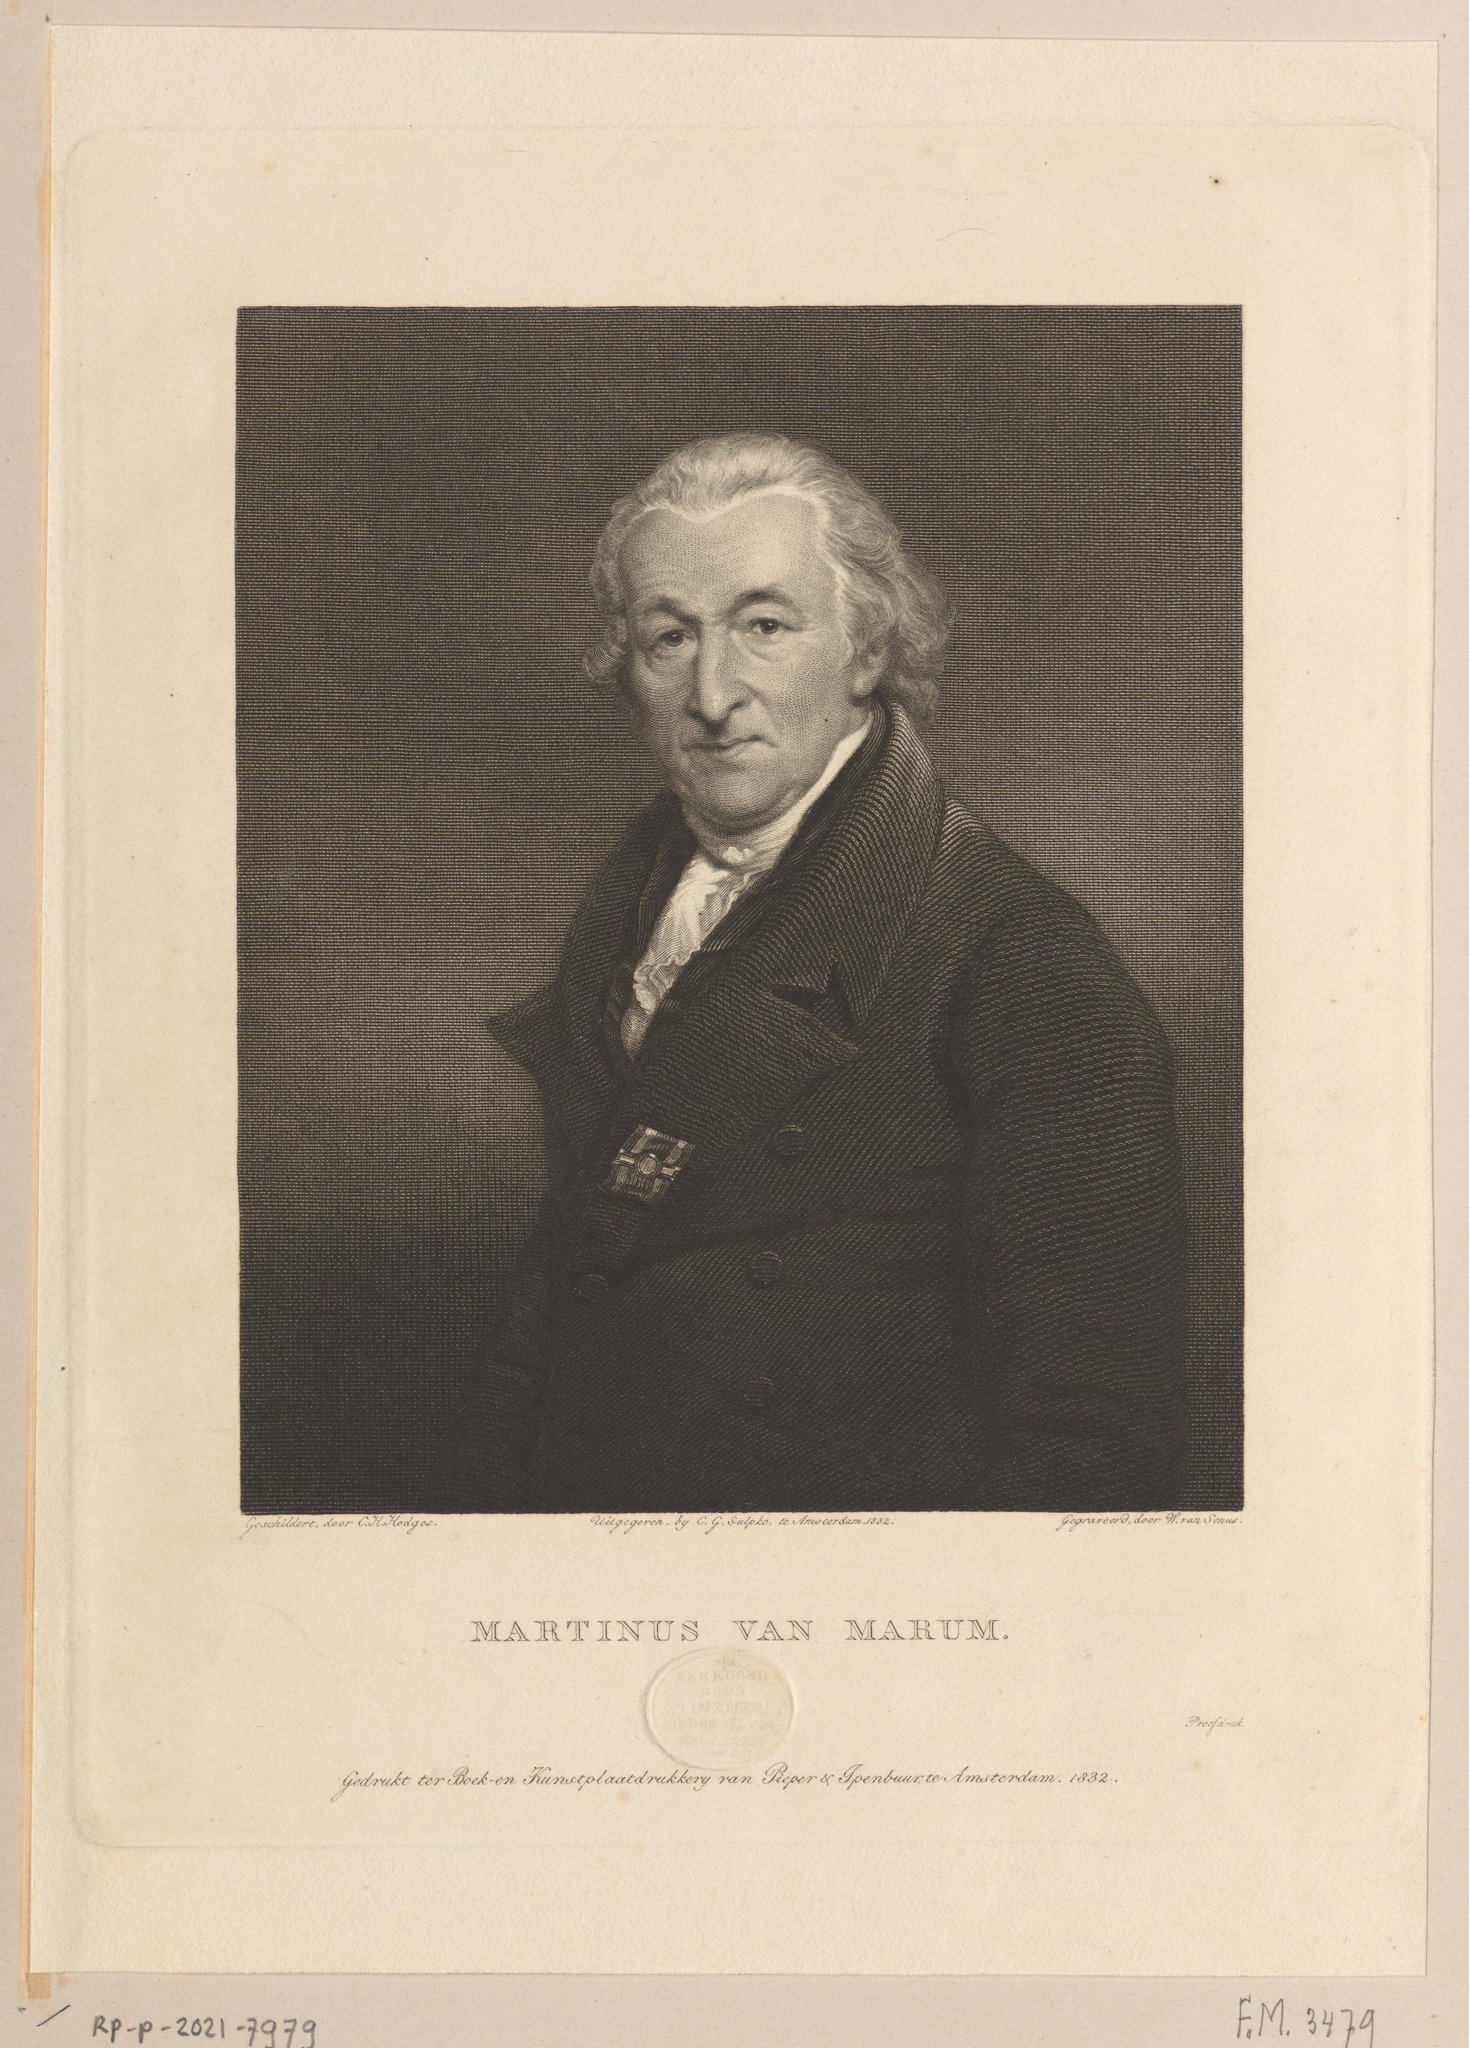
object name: print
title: Portret van Martinus van Marum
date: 1832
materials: paper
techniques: engraving, etching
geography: netherlands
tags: delft, haarlem, historical persons, physician, doctor (+ portrait of scholar, scientist)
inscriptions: check stamp: ‘Bekroond door KN instituut vierde classe MDCCCXXXI’